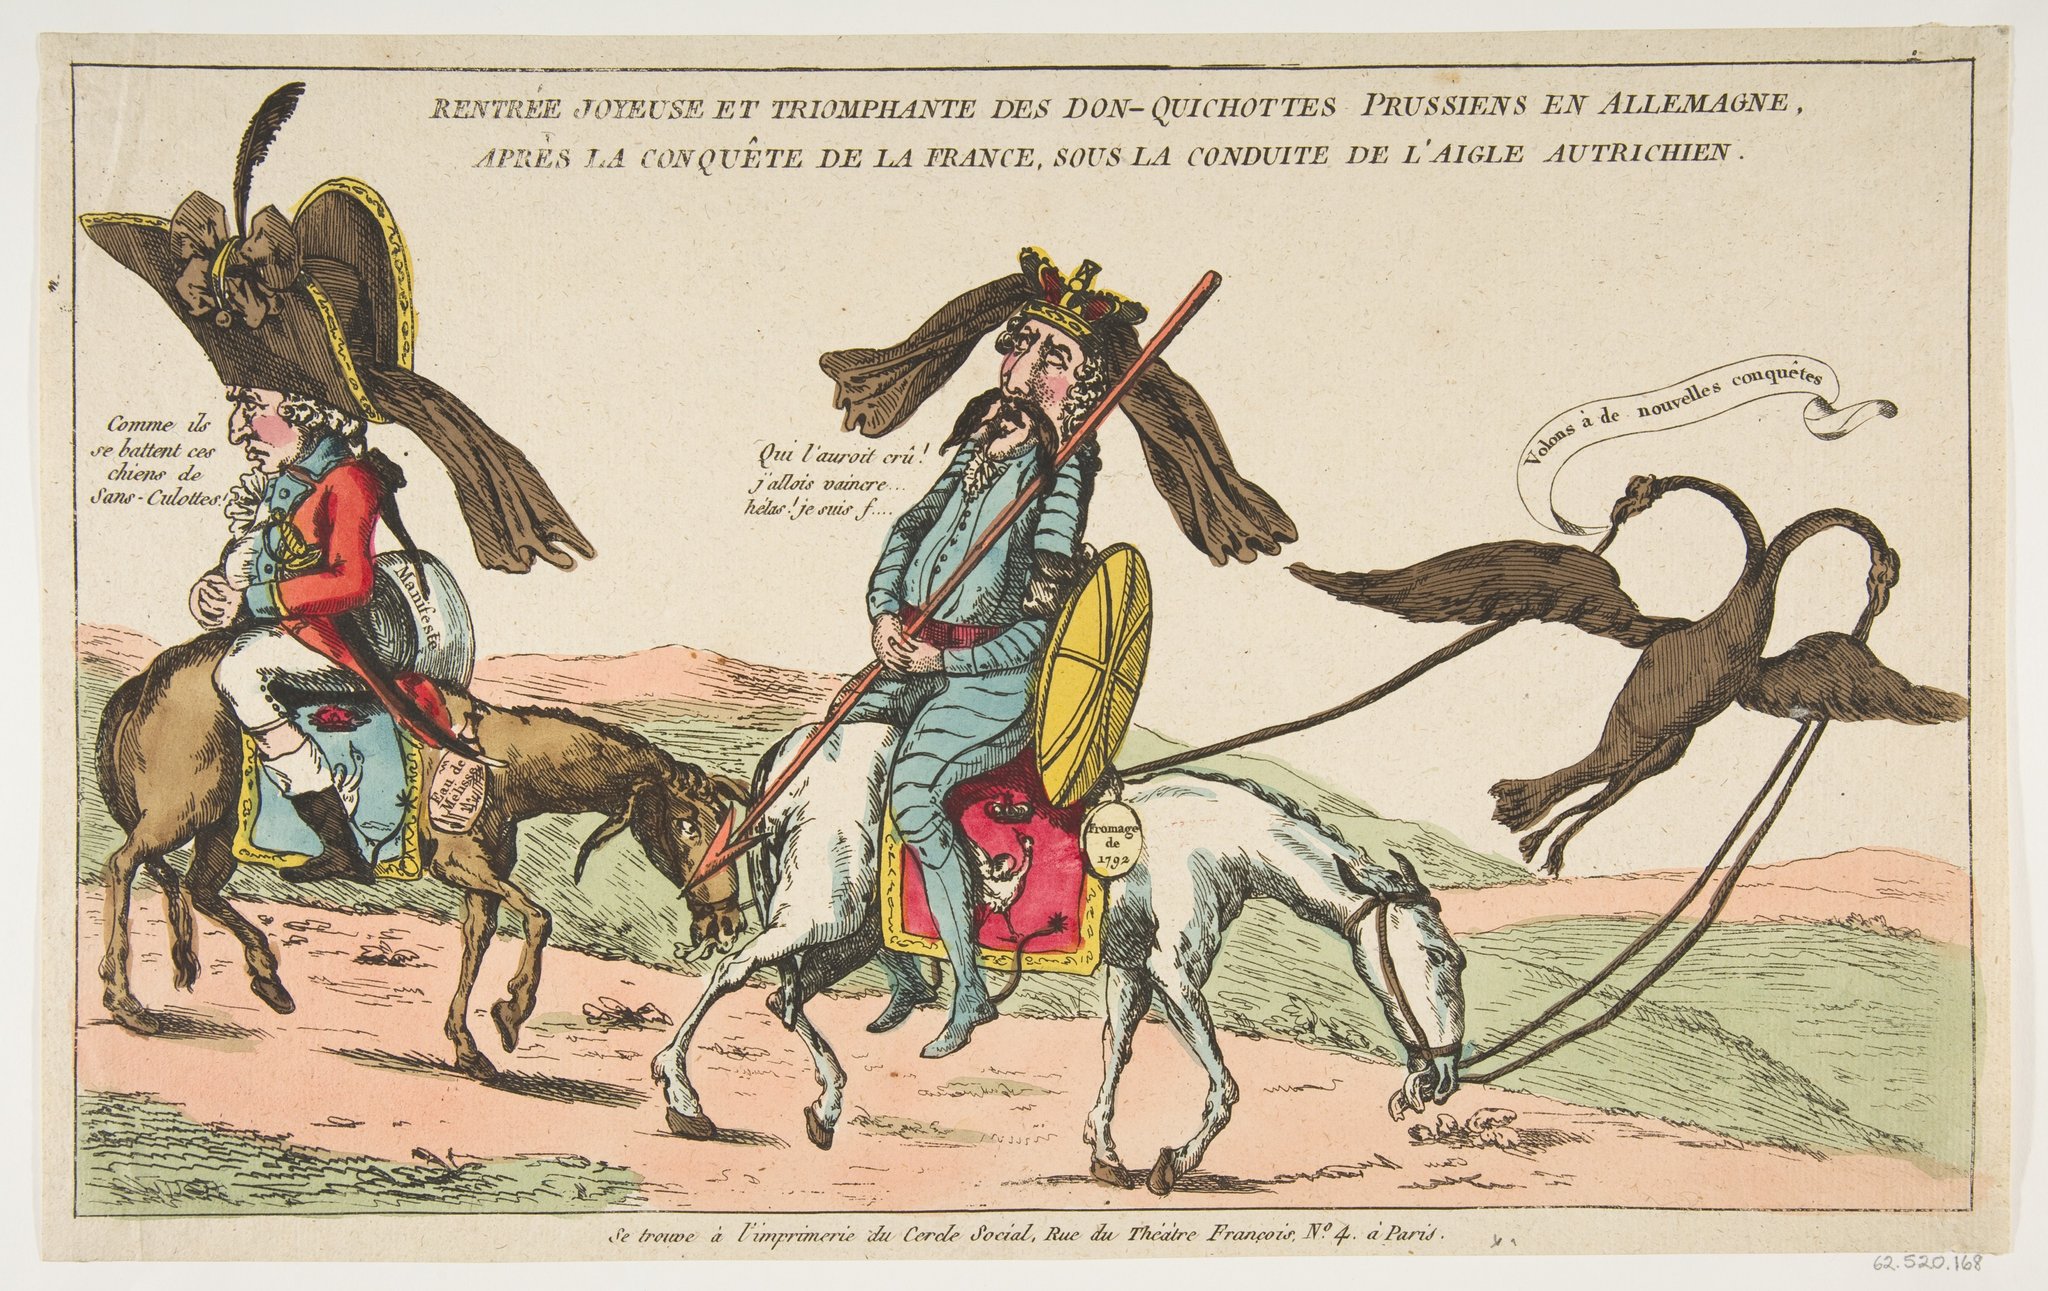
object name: print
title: Rentrée joyeuse et triomphale des Don-Quichottes Prussiens en Allemagne, après la conquête de la France, sous conduite de l'Aigle autrichien (The Joyous Triumphal Entry of the Prussian Don Quixote into Germany after the Conquest of France, Accompanied by the Austrian Eagle)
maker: anonymous, french, 18th century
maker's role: artist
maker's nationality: french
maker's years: 1700-1800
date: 1792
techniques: etching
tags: birds,satire,men,horses,politics,don quixote